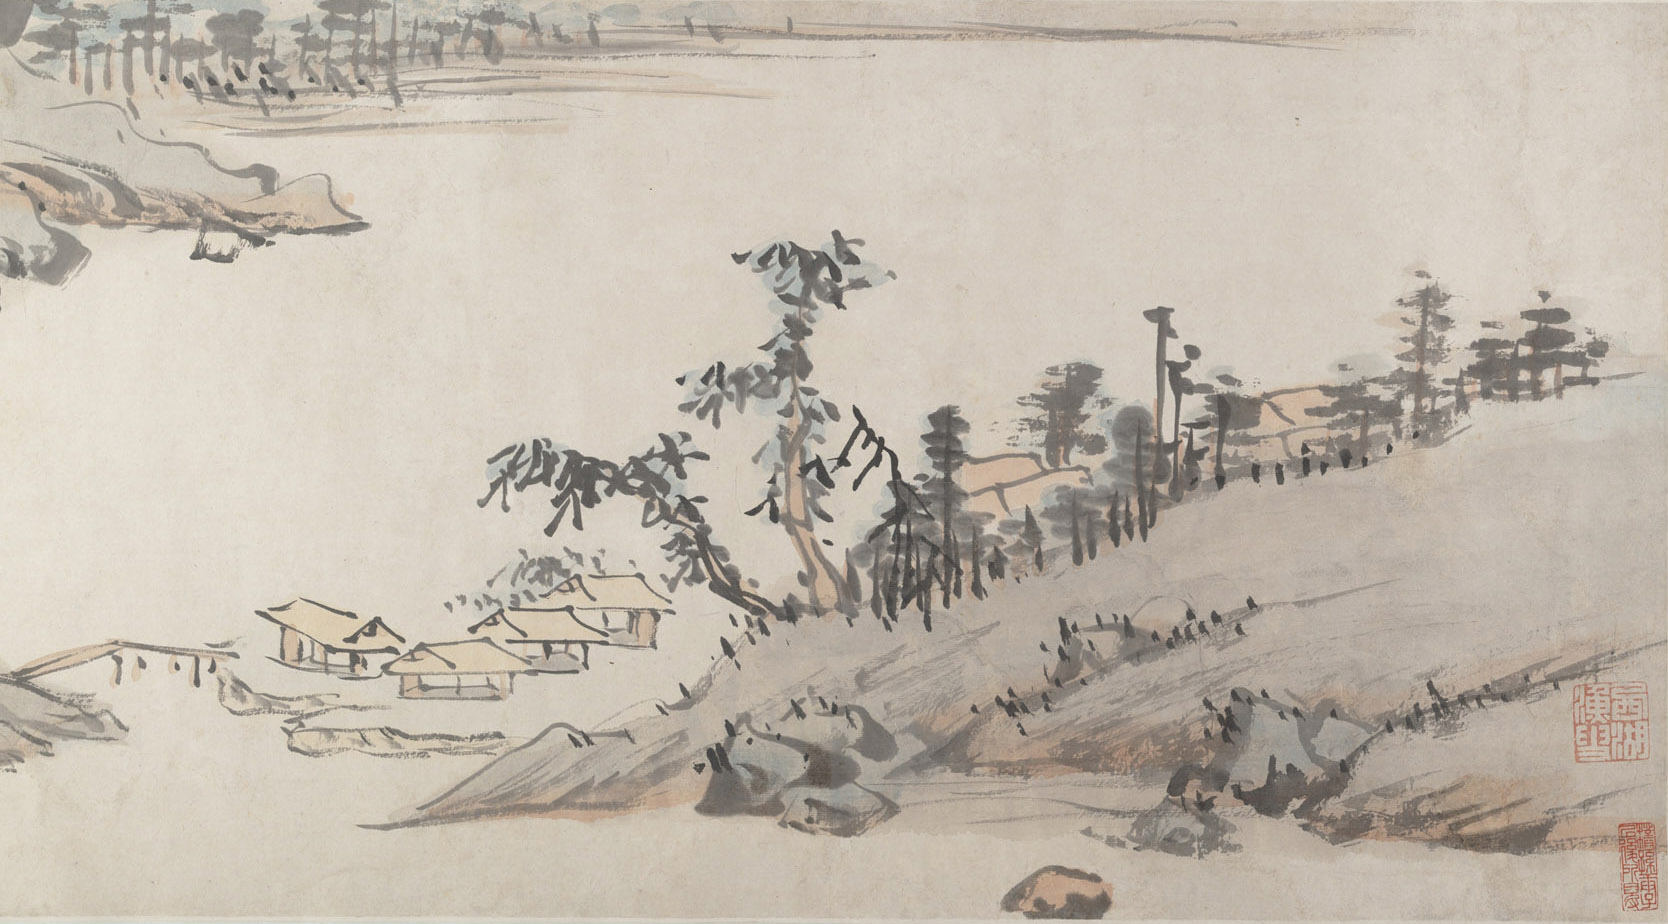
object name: handscroll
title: River Landscape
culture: chinese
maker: chen chun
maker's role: artist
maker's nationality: chinese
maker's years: 1483-1544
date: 1483-1544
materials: ink, paper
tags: rivers,landscapes